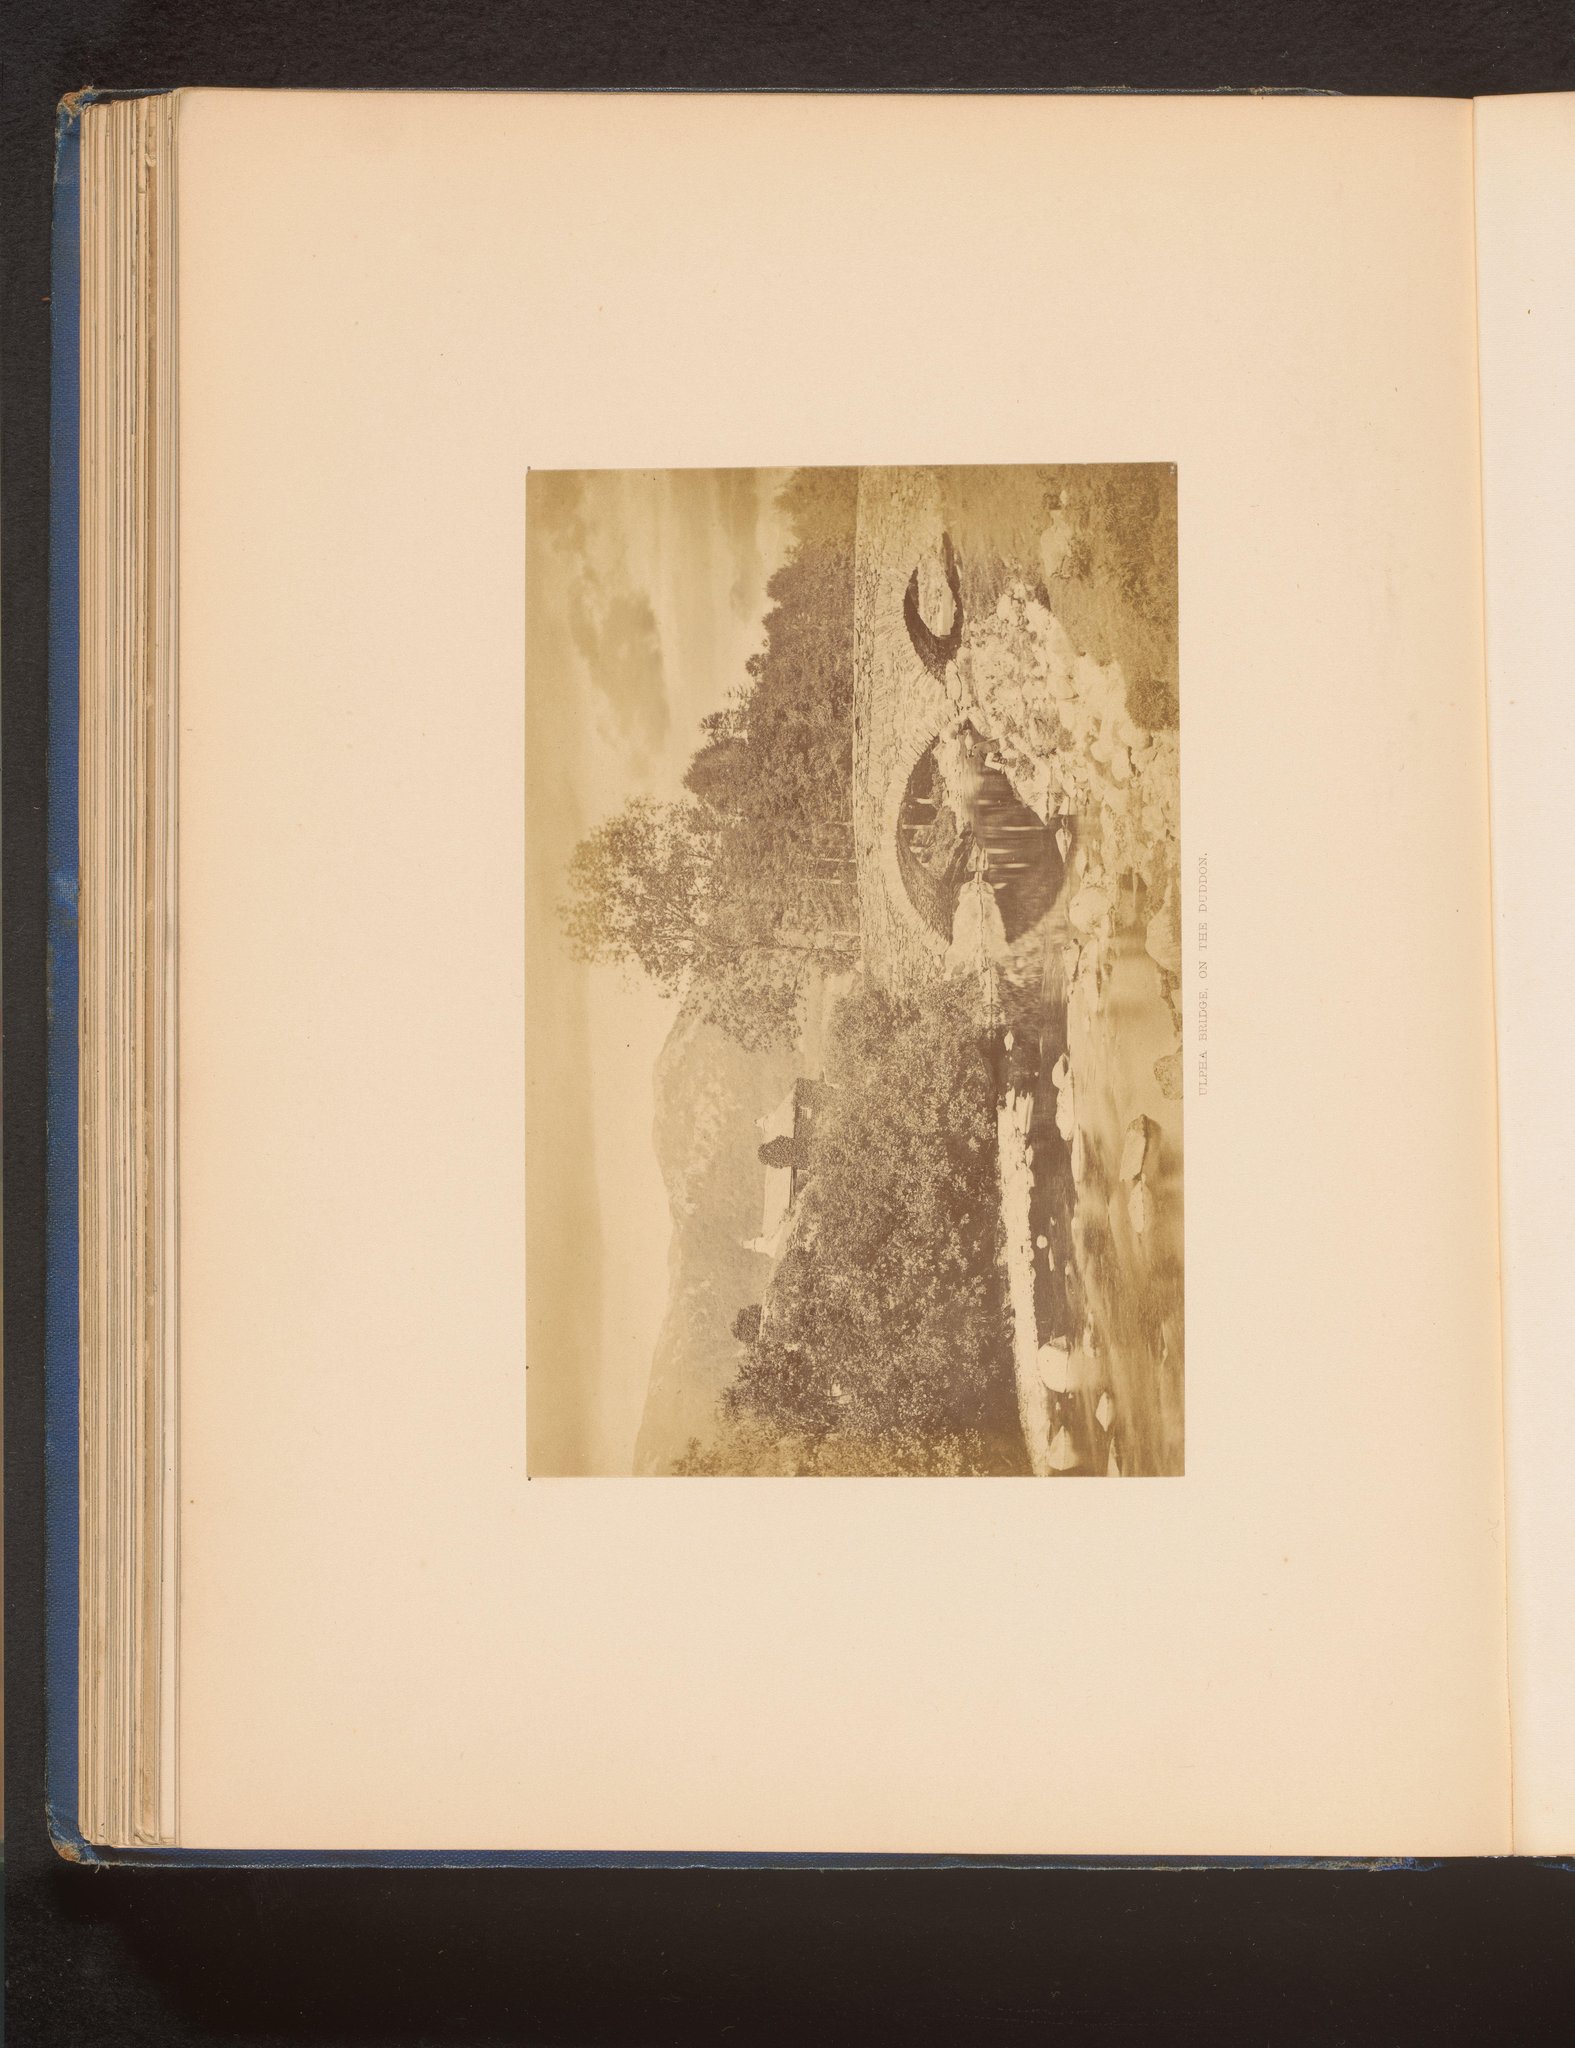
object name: page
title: Brug over de rivier Duddon bij Ulpha in het Lake District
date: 1857-1867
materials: photographic support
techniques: albumen print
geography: lake district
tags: river, bridge